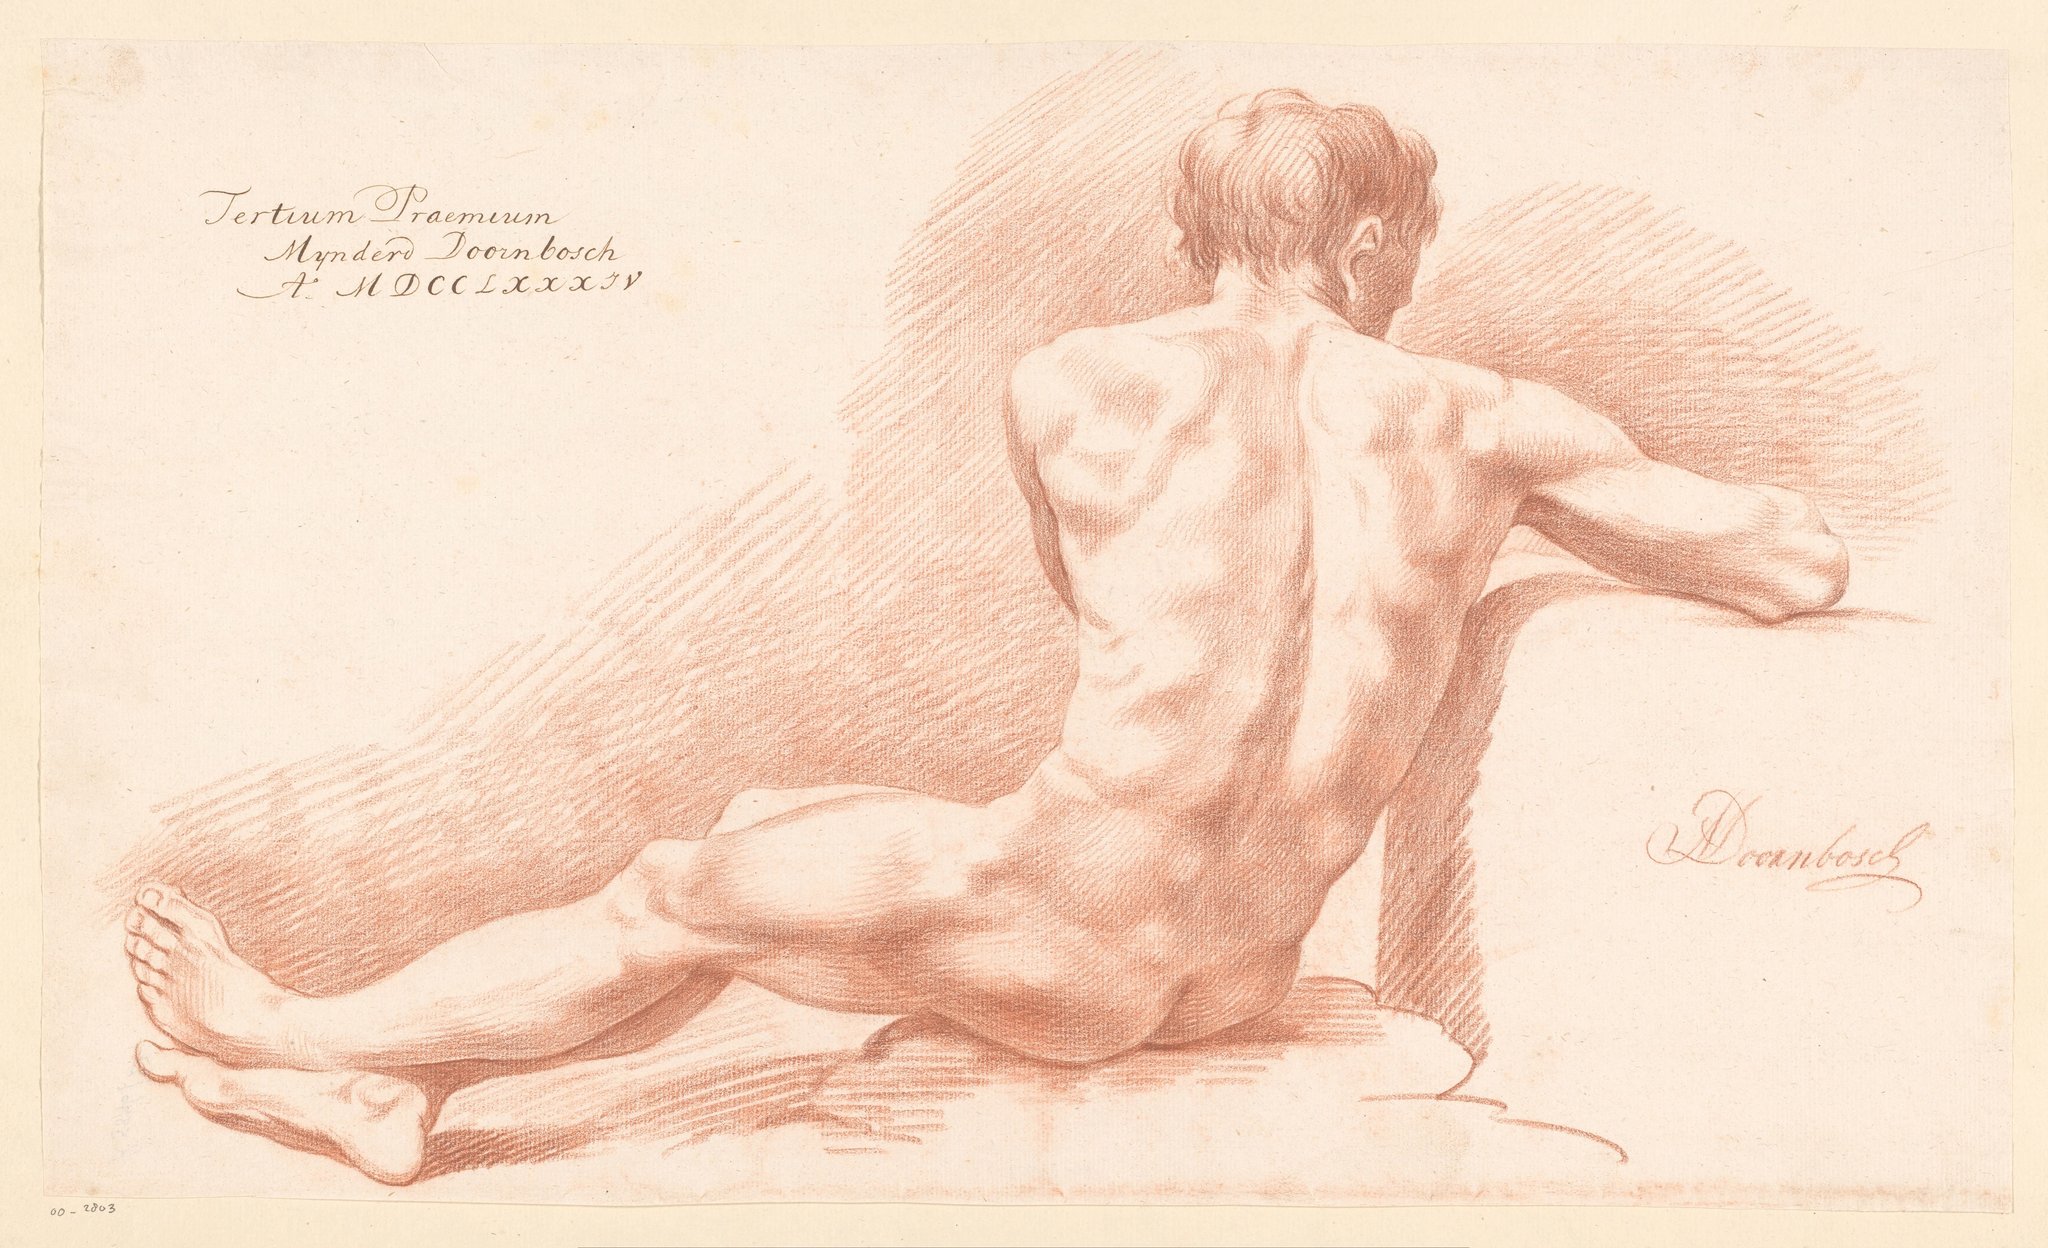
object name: drawing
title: Zittend mannelijk naakt, op de rug gezien (3e prijs 1784)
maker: mijnderd doornbosch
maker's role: draughtsman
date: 1784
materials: chalk, charcoal, paper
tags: sitting figure (+ nude human being)